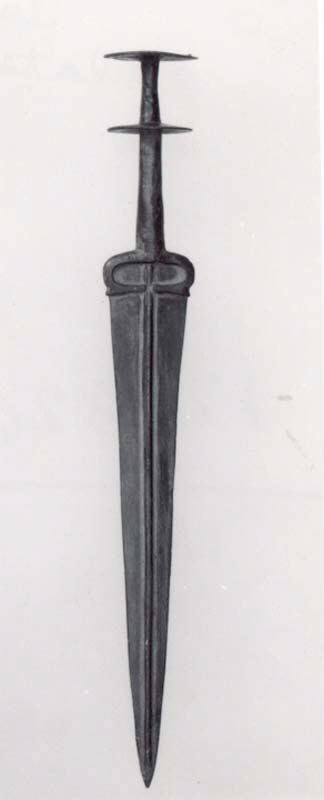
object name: dagger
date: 1000-701 BCE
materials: bronze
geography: northwestern iran, caspian region